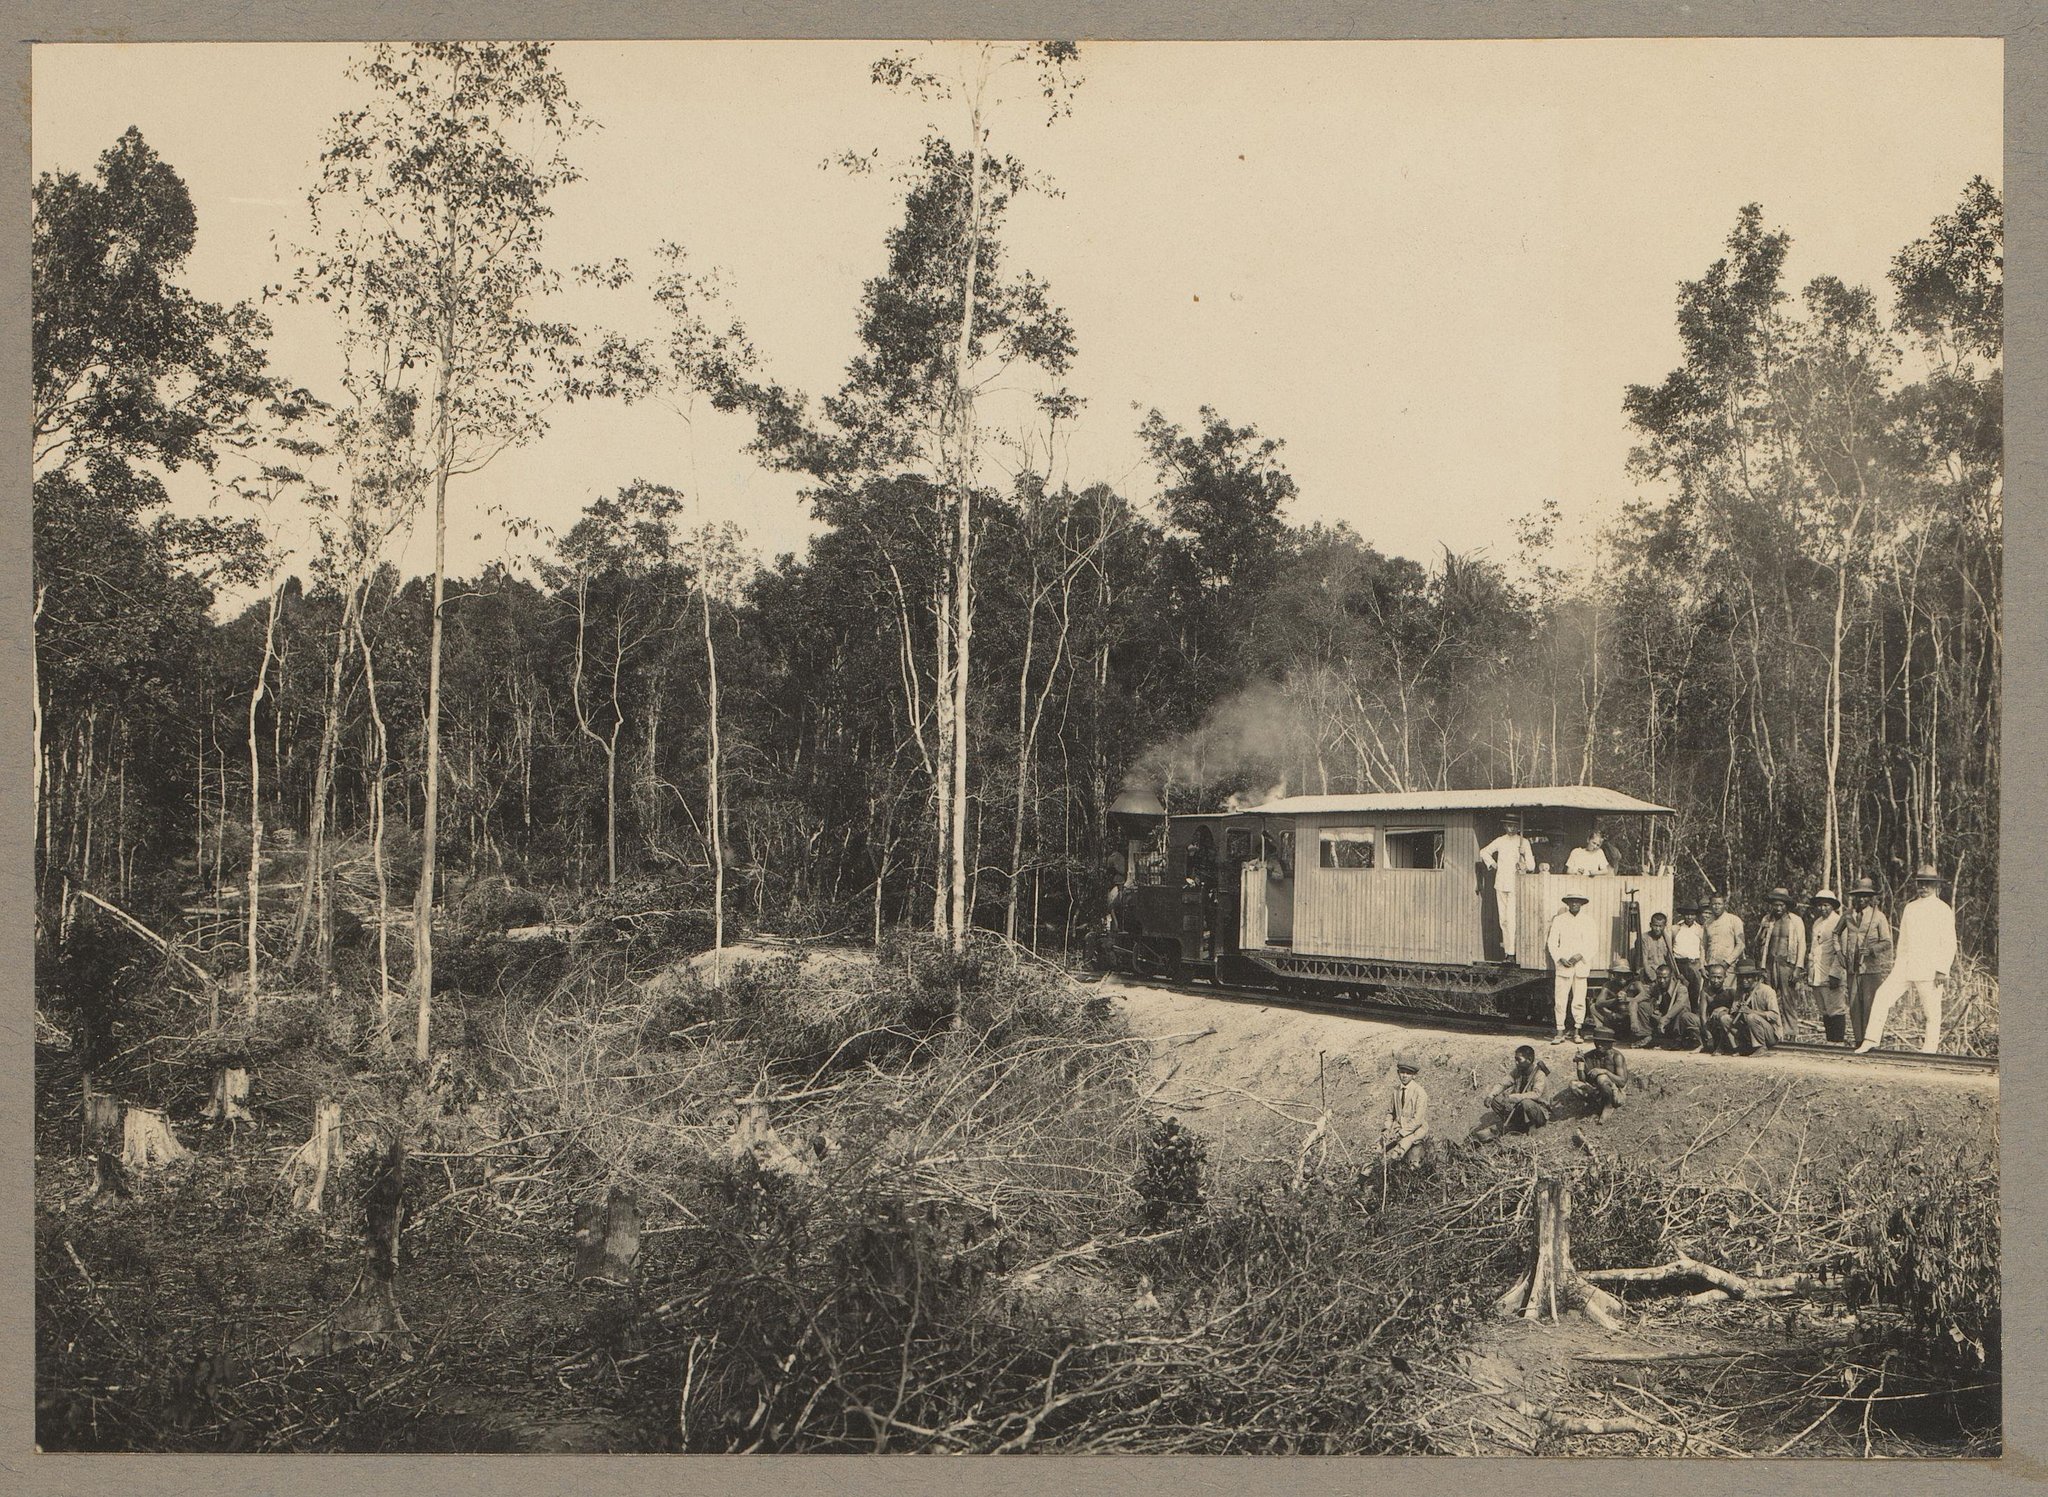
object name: photograph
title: Eindpunt zijlijn Aer Bankoewang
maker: Anonymous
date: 1914-1919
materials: photographic support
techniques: gelatin silver print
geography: bangka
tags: robert julius boers, colonial system, mining, railway-traffic (+ propulsion of vehicle, ship, etc. by steam)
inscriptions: inscription: ‘Eindpunt zijlijn Aer Bankoewang’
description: Eindpunt in het bos van een lijn van de stoomtram van de Banka-tinwinning. Onderdeel van het fotoalbum aangeboden aan Robert Julius Boers bij zijn vertrek naar Nederland in 1919 door het personeel van de Banka-tinwinning.